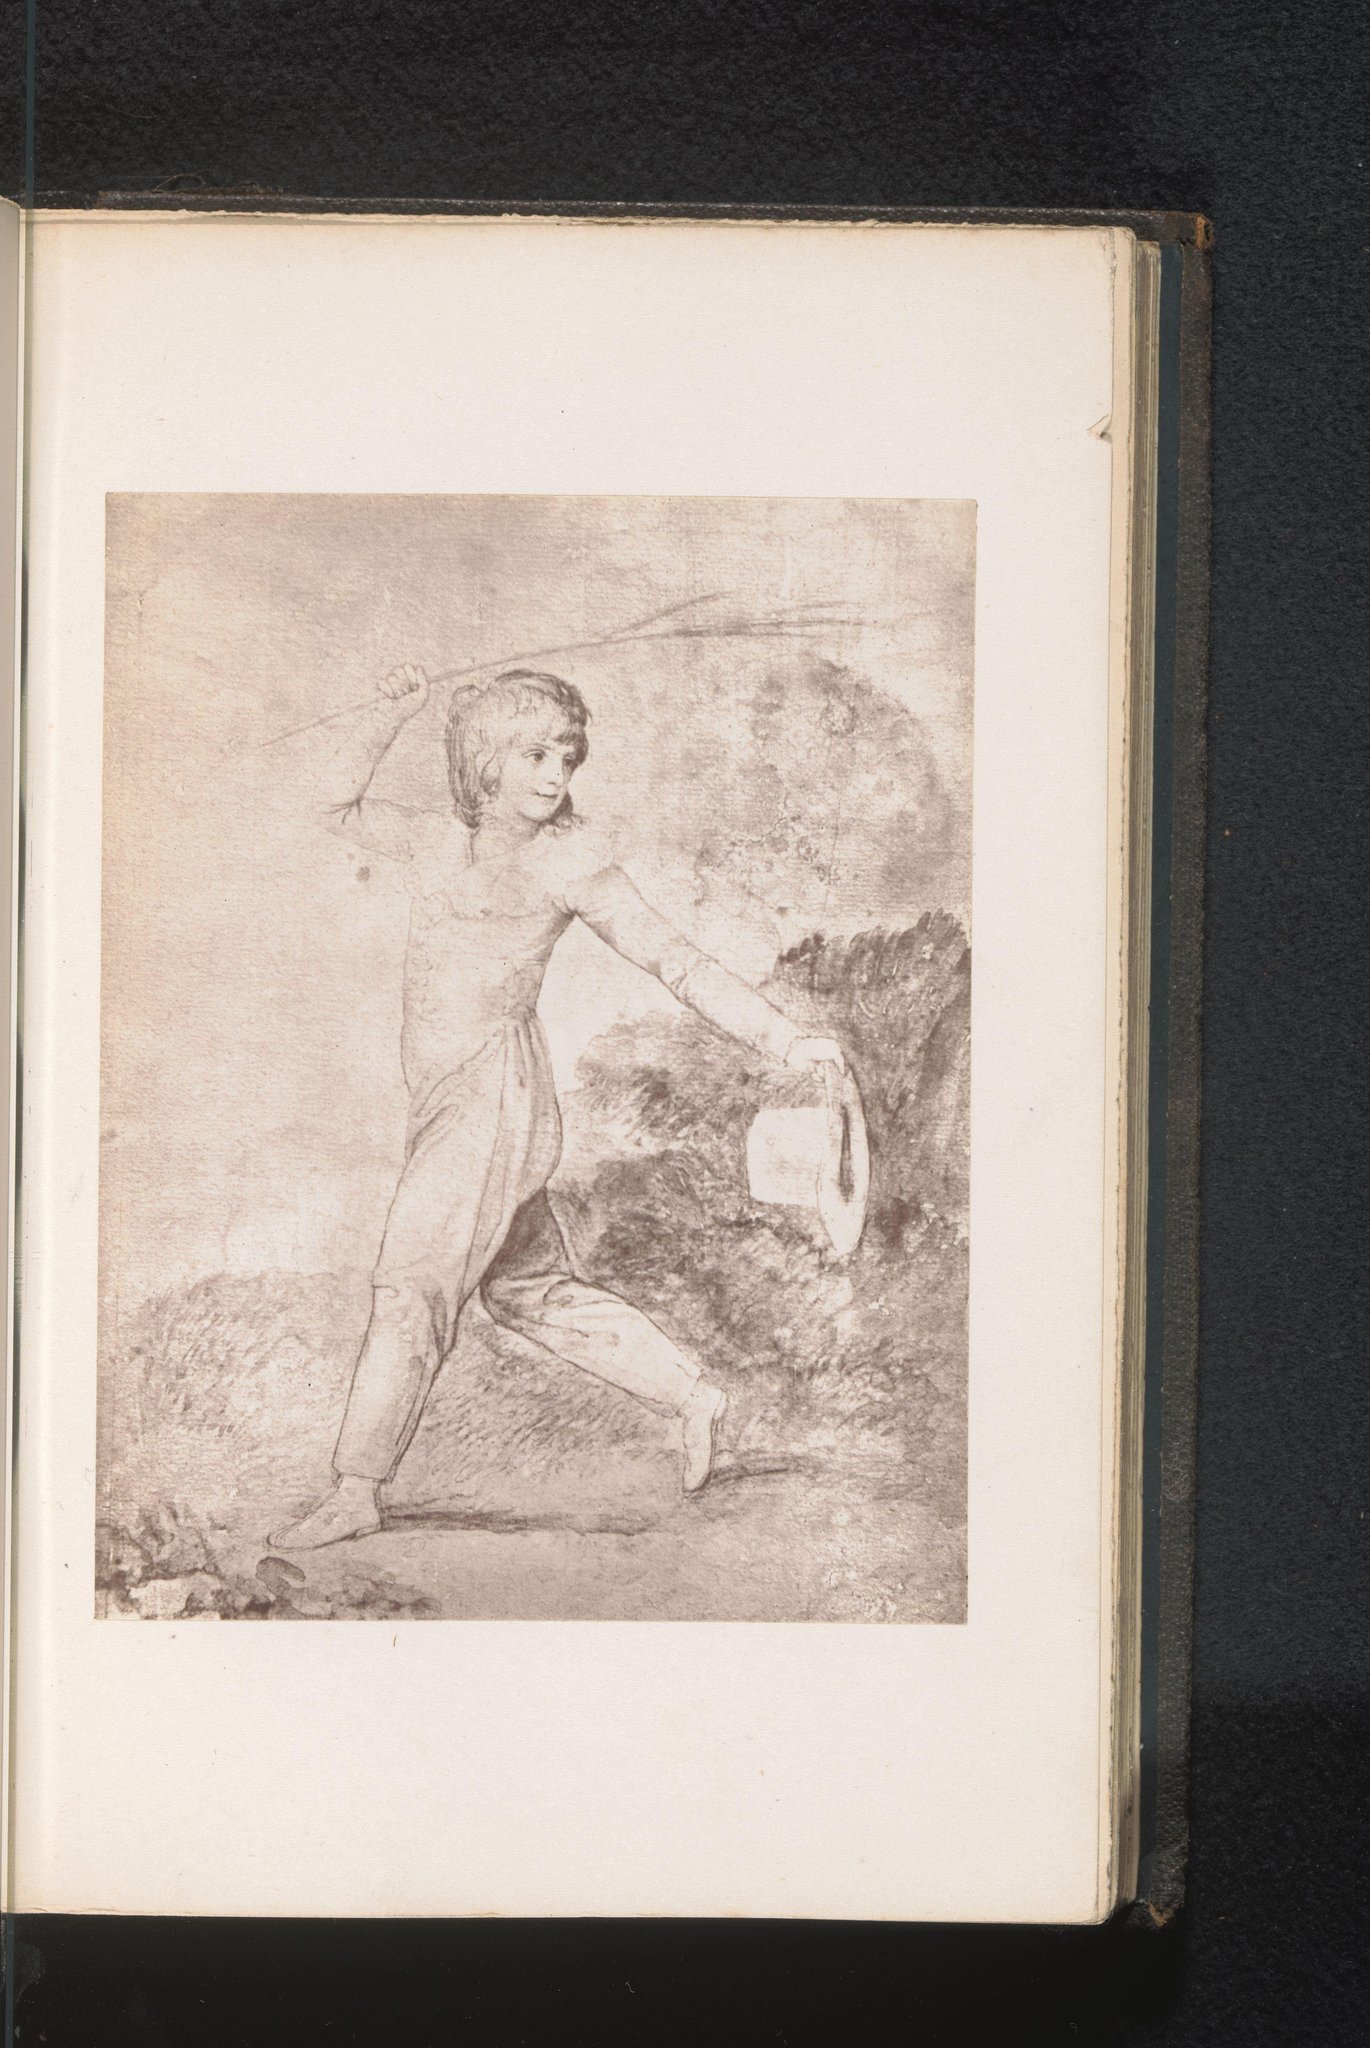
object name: page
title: Fotoreproductie van een tekening, voorstellende een portret van Francis George Hare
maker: Anonymous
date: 1866-1876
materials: paper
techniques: woodburytype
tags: youth, adolescent